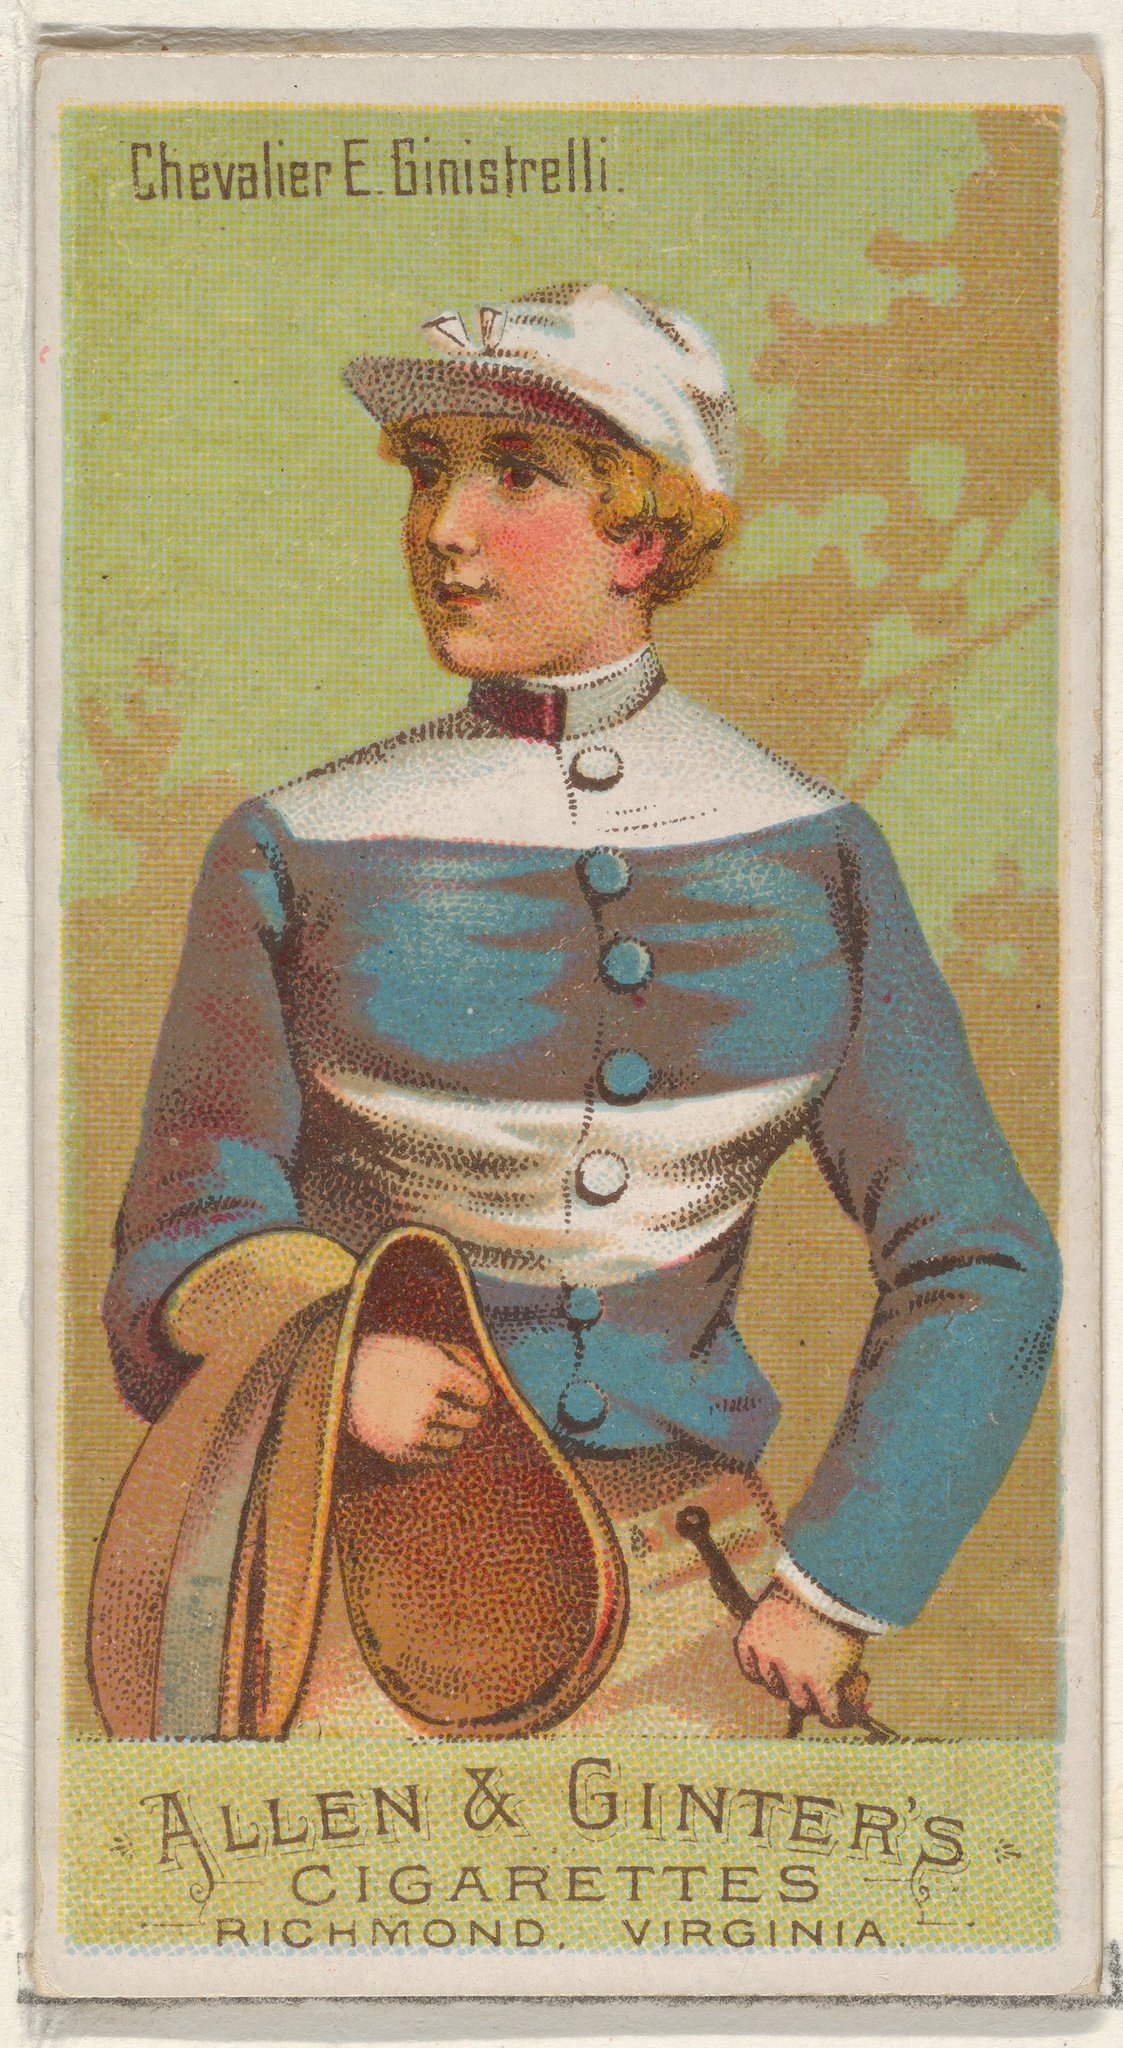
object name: print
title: Chevalier E. Ginistrelli, from the Racing Colors of the World series (N22a) for Allen & Ginter Cigarettes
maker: allen & ginter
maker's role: publisher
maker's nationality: american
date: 1888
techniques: color lithograph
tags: women,jockeys